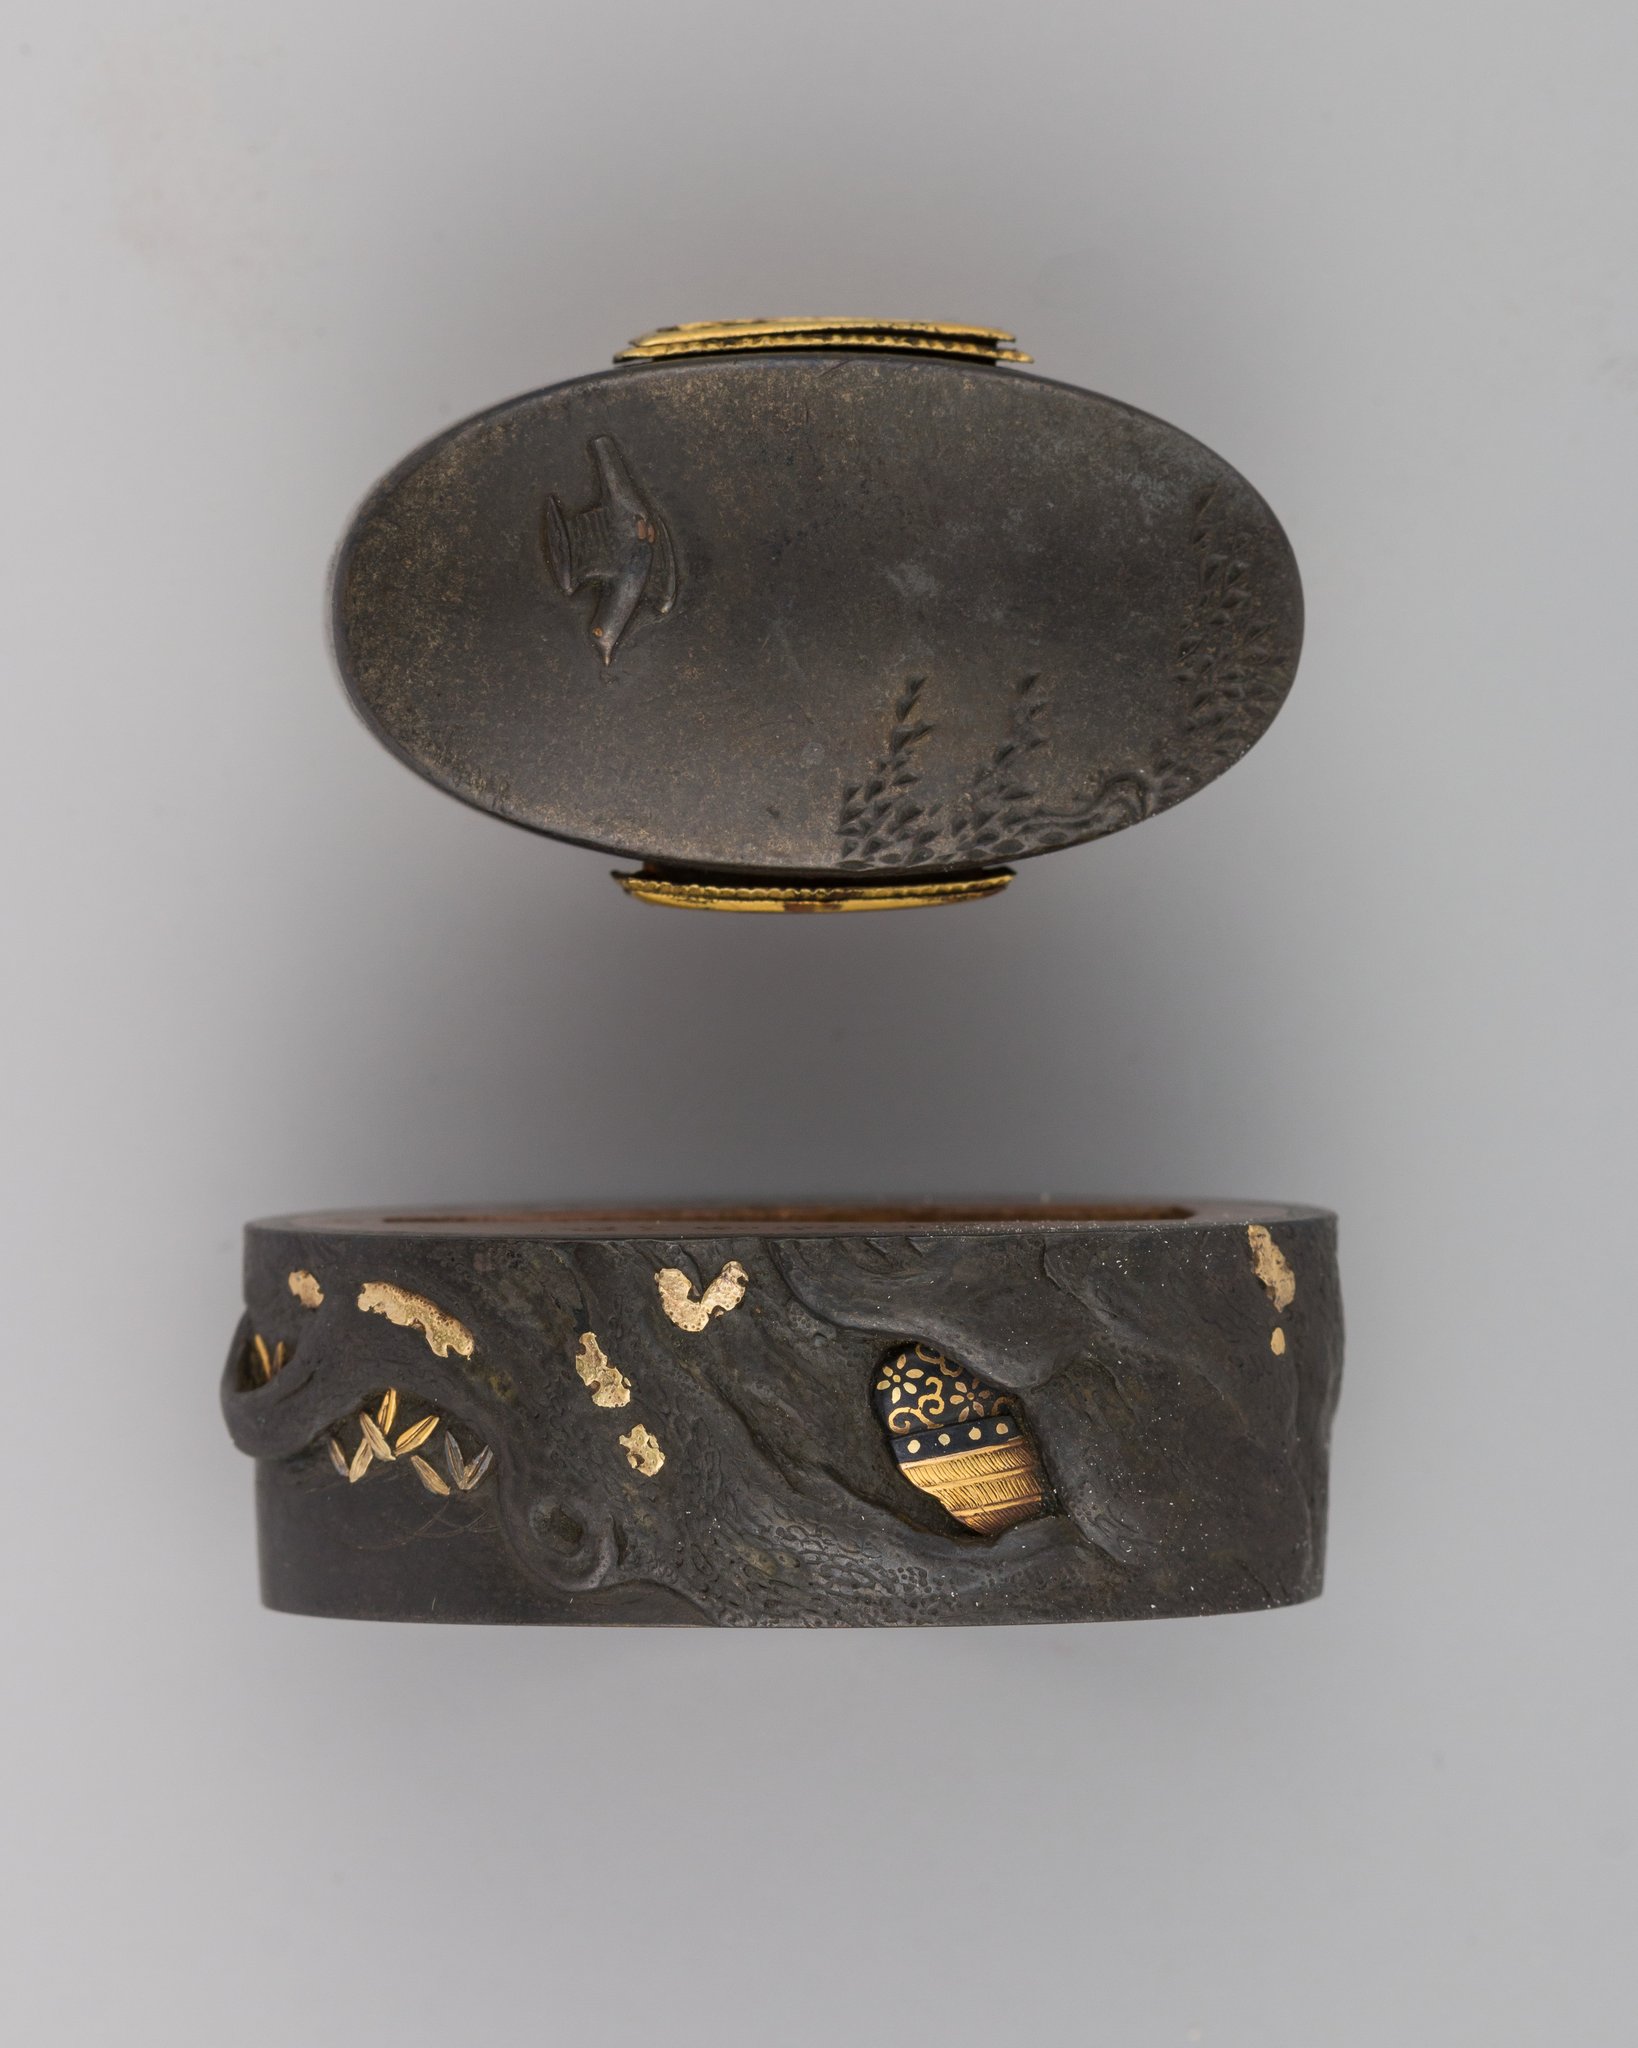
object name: sword hilt collar and pommel fuchigashira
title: Sword-Hilt Collar and Pommel (Fuchigashira)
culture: japanese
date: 1701-1800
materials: gold alloy, silver alloy, gold, silver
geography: japan